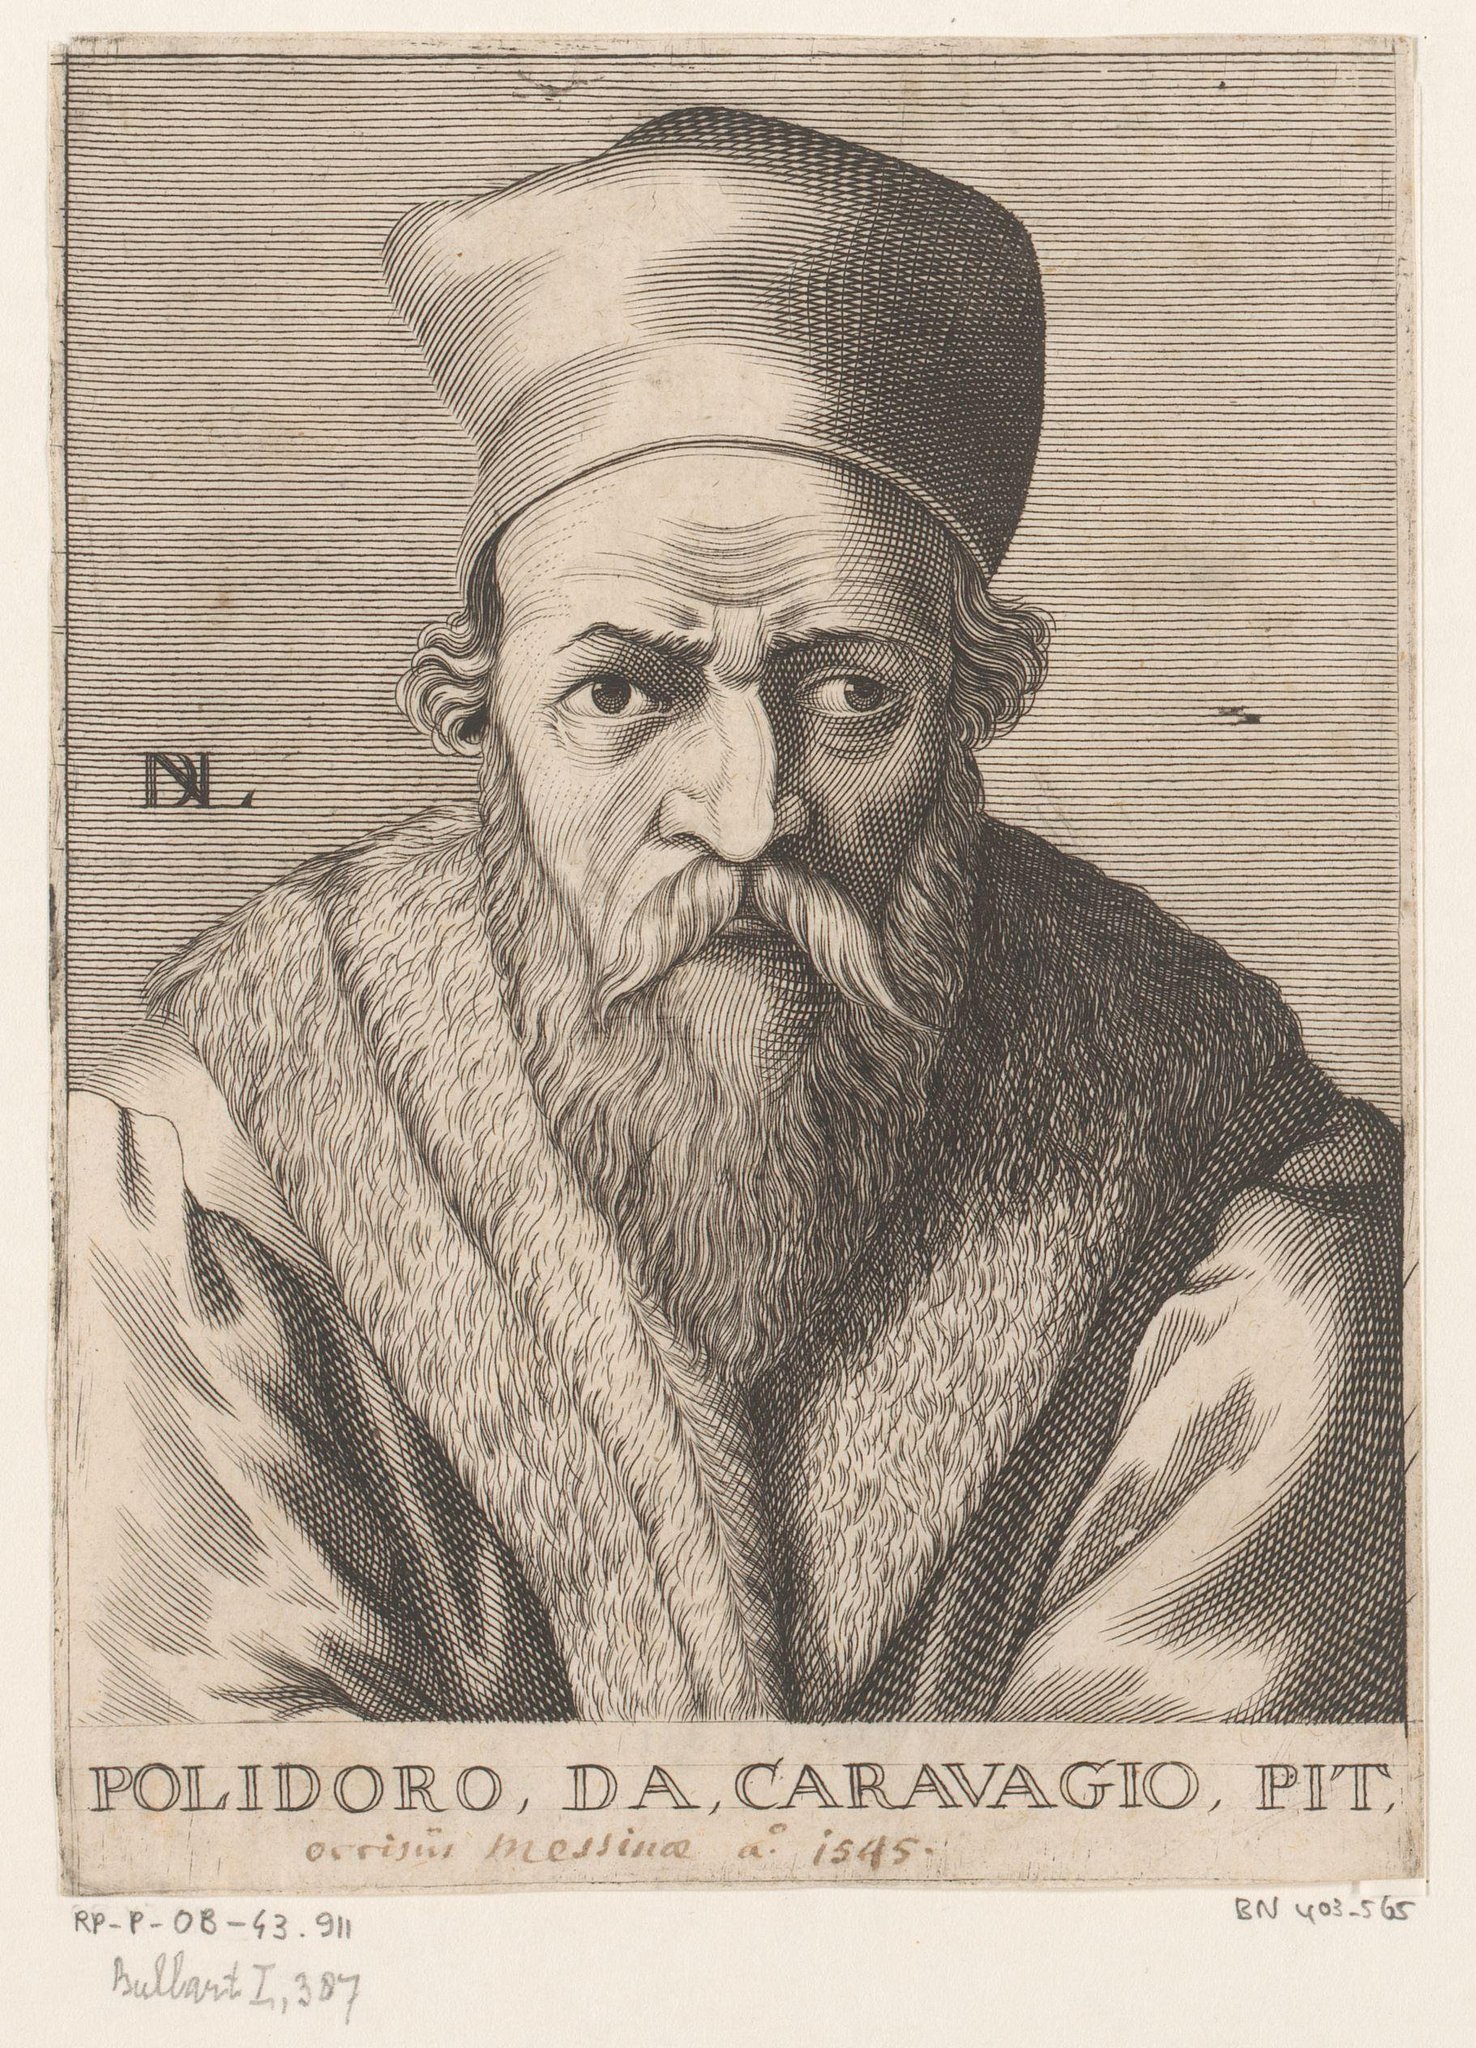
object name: print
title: Portret van Polidoro da Caravaggio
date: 1682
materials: paper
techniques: engraving, letterpress printing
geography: brussels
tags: draughtsman, polidoro da caravaggio, historical persons, portrait, self-portrait of artist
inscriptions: collector's mark: Lugt 2228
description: Prent gebruikt voor: Bullart, Isaac. Académie des Sciences et Arts contenant les vies et éloges his. des hommes illustres qui ont excellé en ces professions depuis environ quatre siècles. Brussel: François Foppens, 1682. Het boek werd in 1682 eveneens in Amsterdam uitgegeven door de erfgenamen van Daniel Elzevier. Ieder portret betreft een illustratie bij de biografie van een kunstenaar of geleerde. De meeste portretten werden door Nicolas de Larmessin vervaardigd (162), 93 door De Boulonois en een derde door ongeïdentificeerde prentmakers. Dit betreft een illustratie op p. 387, deel I.